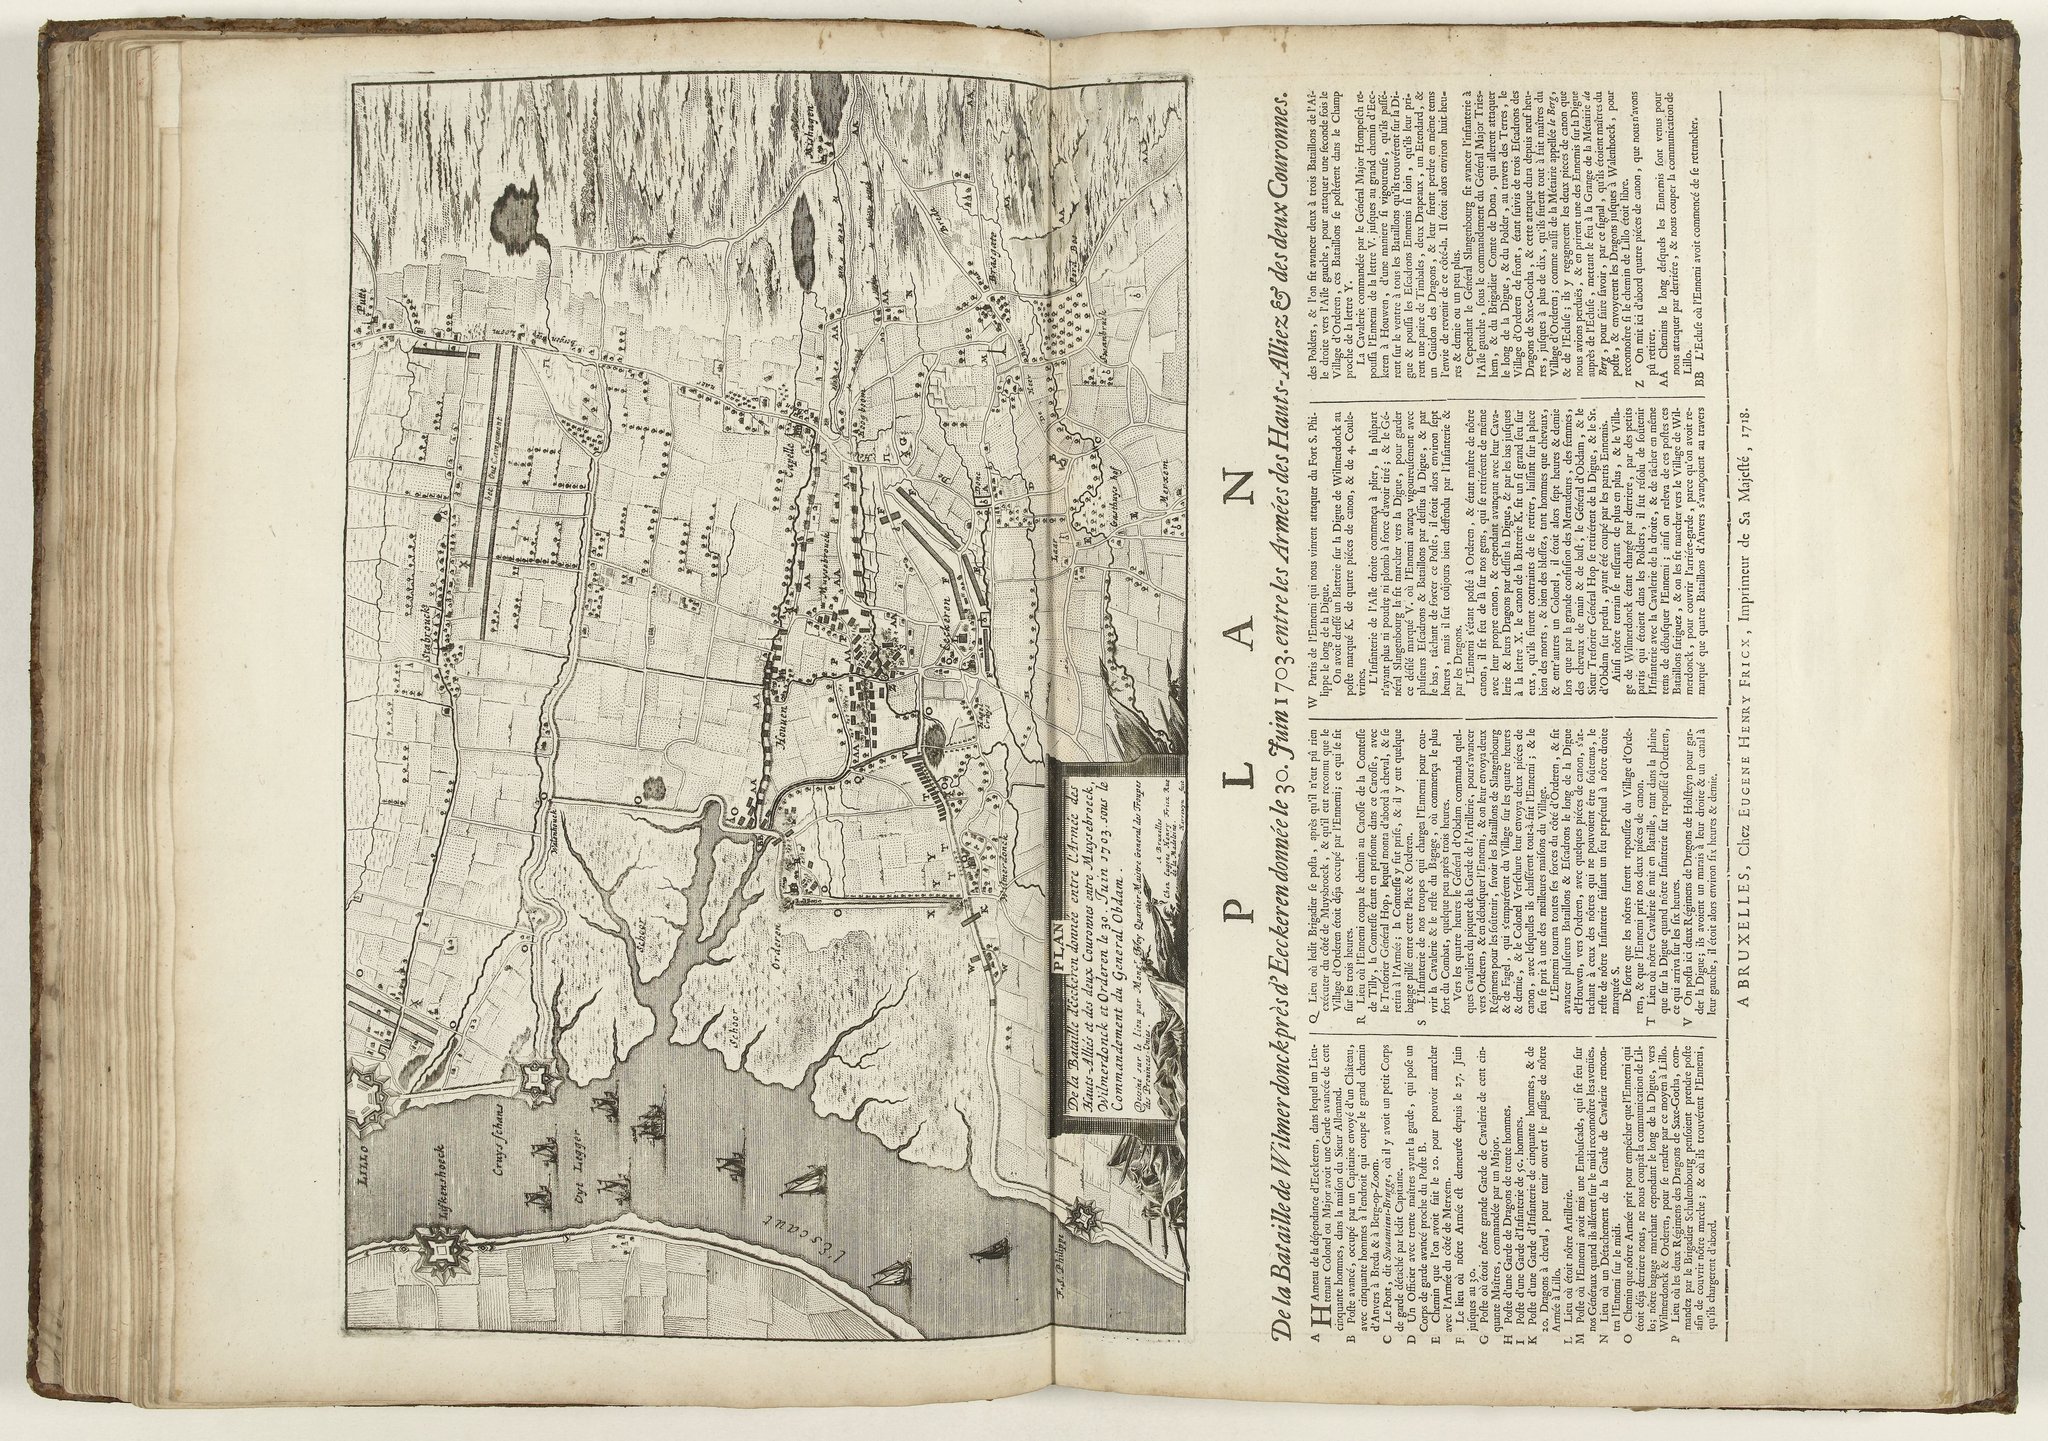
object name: print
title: Slag bij Ekeren, 1703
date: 1703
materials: paper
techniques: etching, letterpress printing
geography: brussels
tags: maps of separate countries or regions, battle (+ land forces)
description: Slag bij Ekeren. Overwinning van een Frans leger op de Nederlanders onder Jacob II van Wassenaer Obdam bij Ekeren, 30 juni 1703. Op het blad onder de plaat staat een gedrukte verklaring van de voorstelling in het Frans. Onderdeel van een gebundelde verzameling van plannen van veldslagen en steden vermaard in de Spaanse Successieoorlog.